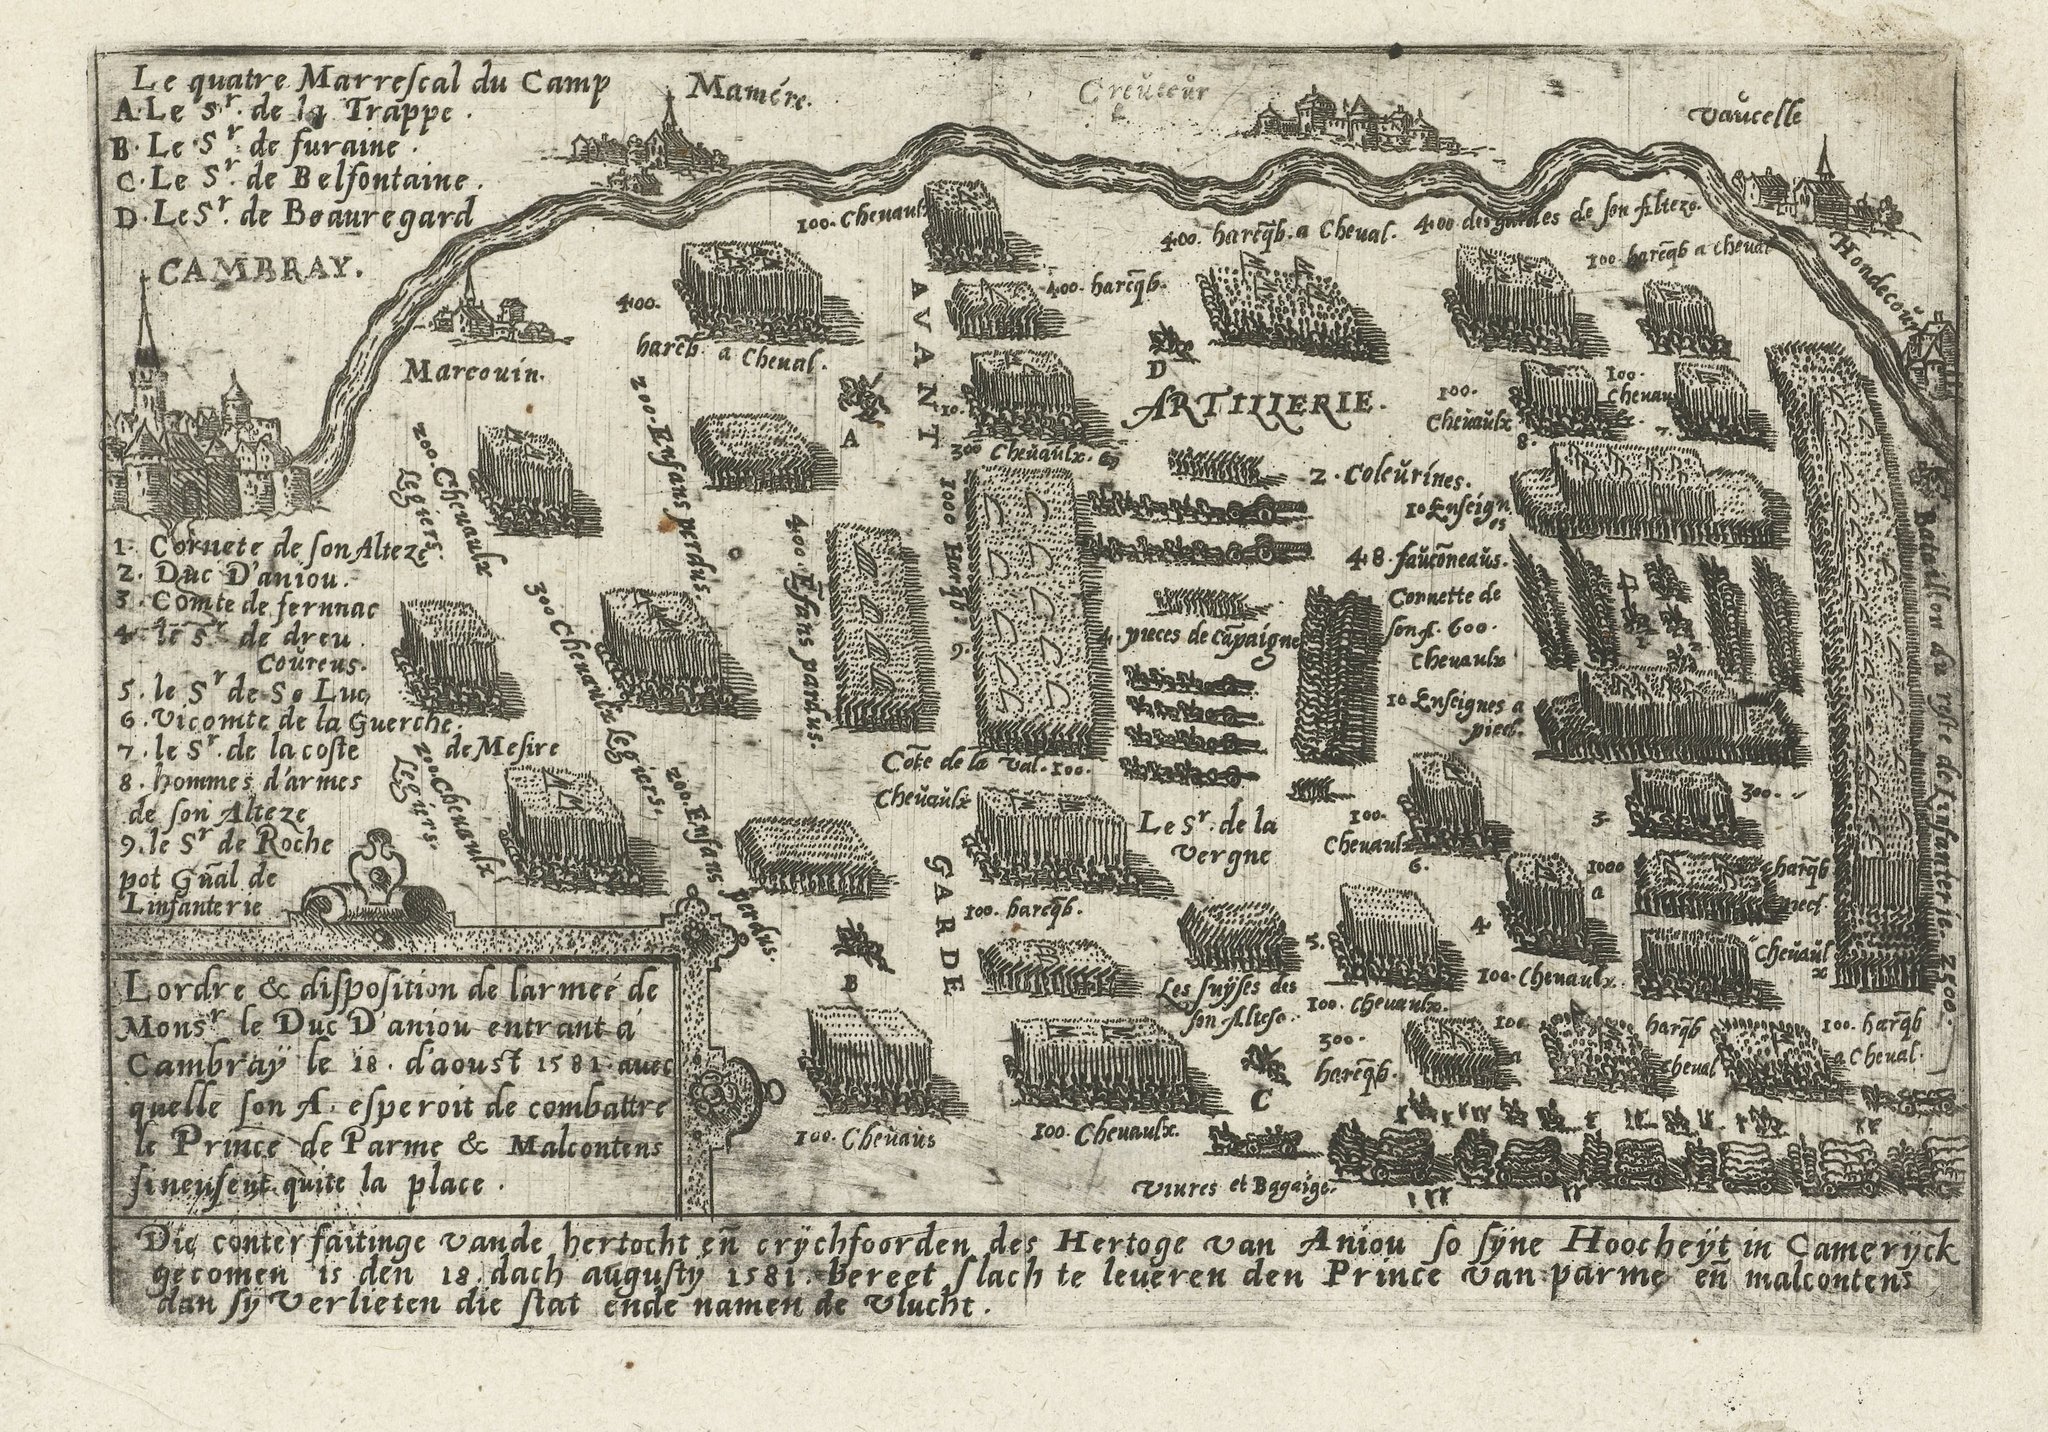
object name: history print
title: De hertog van Anjou tracht na het ontzet van Kamerijk de hertog van Parma tot een treffen uit te lokken, 1581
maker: Anonymous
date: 1610-1624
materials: paper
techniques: etching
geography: low countries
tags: paris, françois-hercule de valois (hertog van anjou), troop movements, transportation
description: De hertog van Anjou tracht na het ontzet van Kamerijk de hertog van Parma tot een treffen uit te lokken, 18 augustus 1581. Marsorde van de troepen van Anjou bij Kamerijk. Links de legenda's A-D en 1-9 en linksonder een cartouche met tekst in het Frans, in het onderschrift 3 regels in het Nederlands. Ongenummerd en onbedrukt op achterzijde.